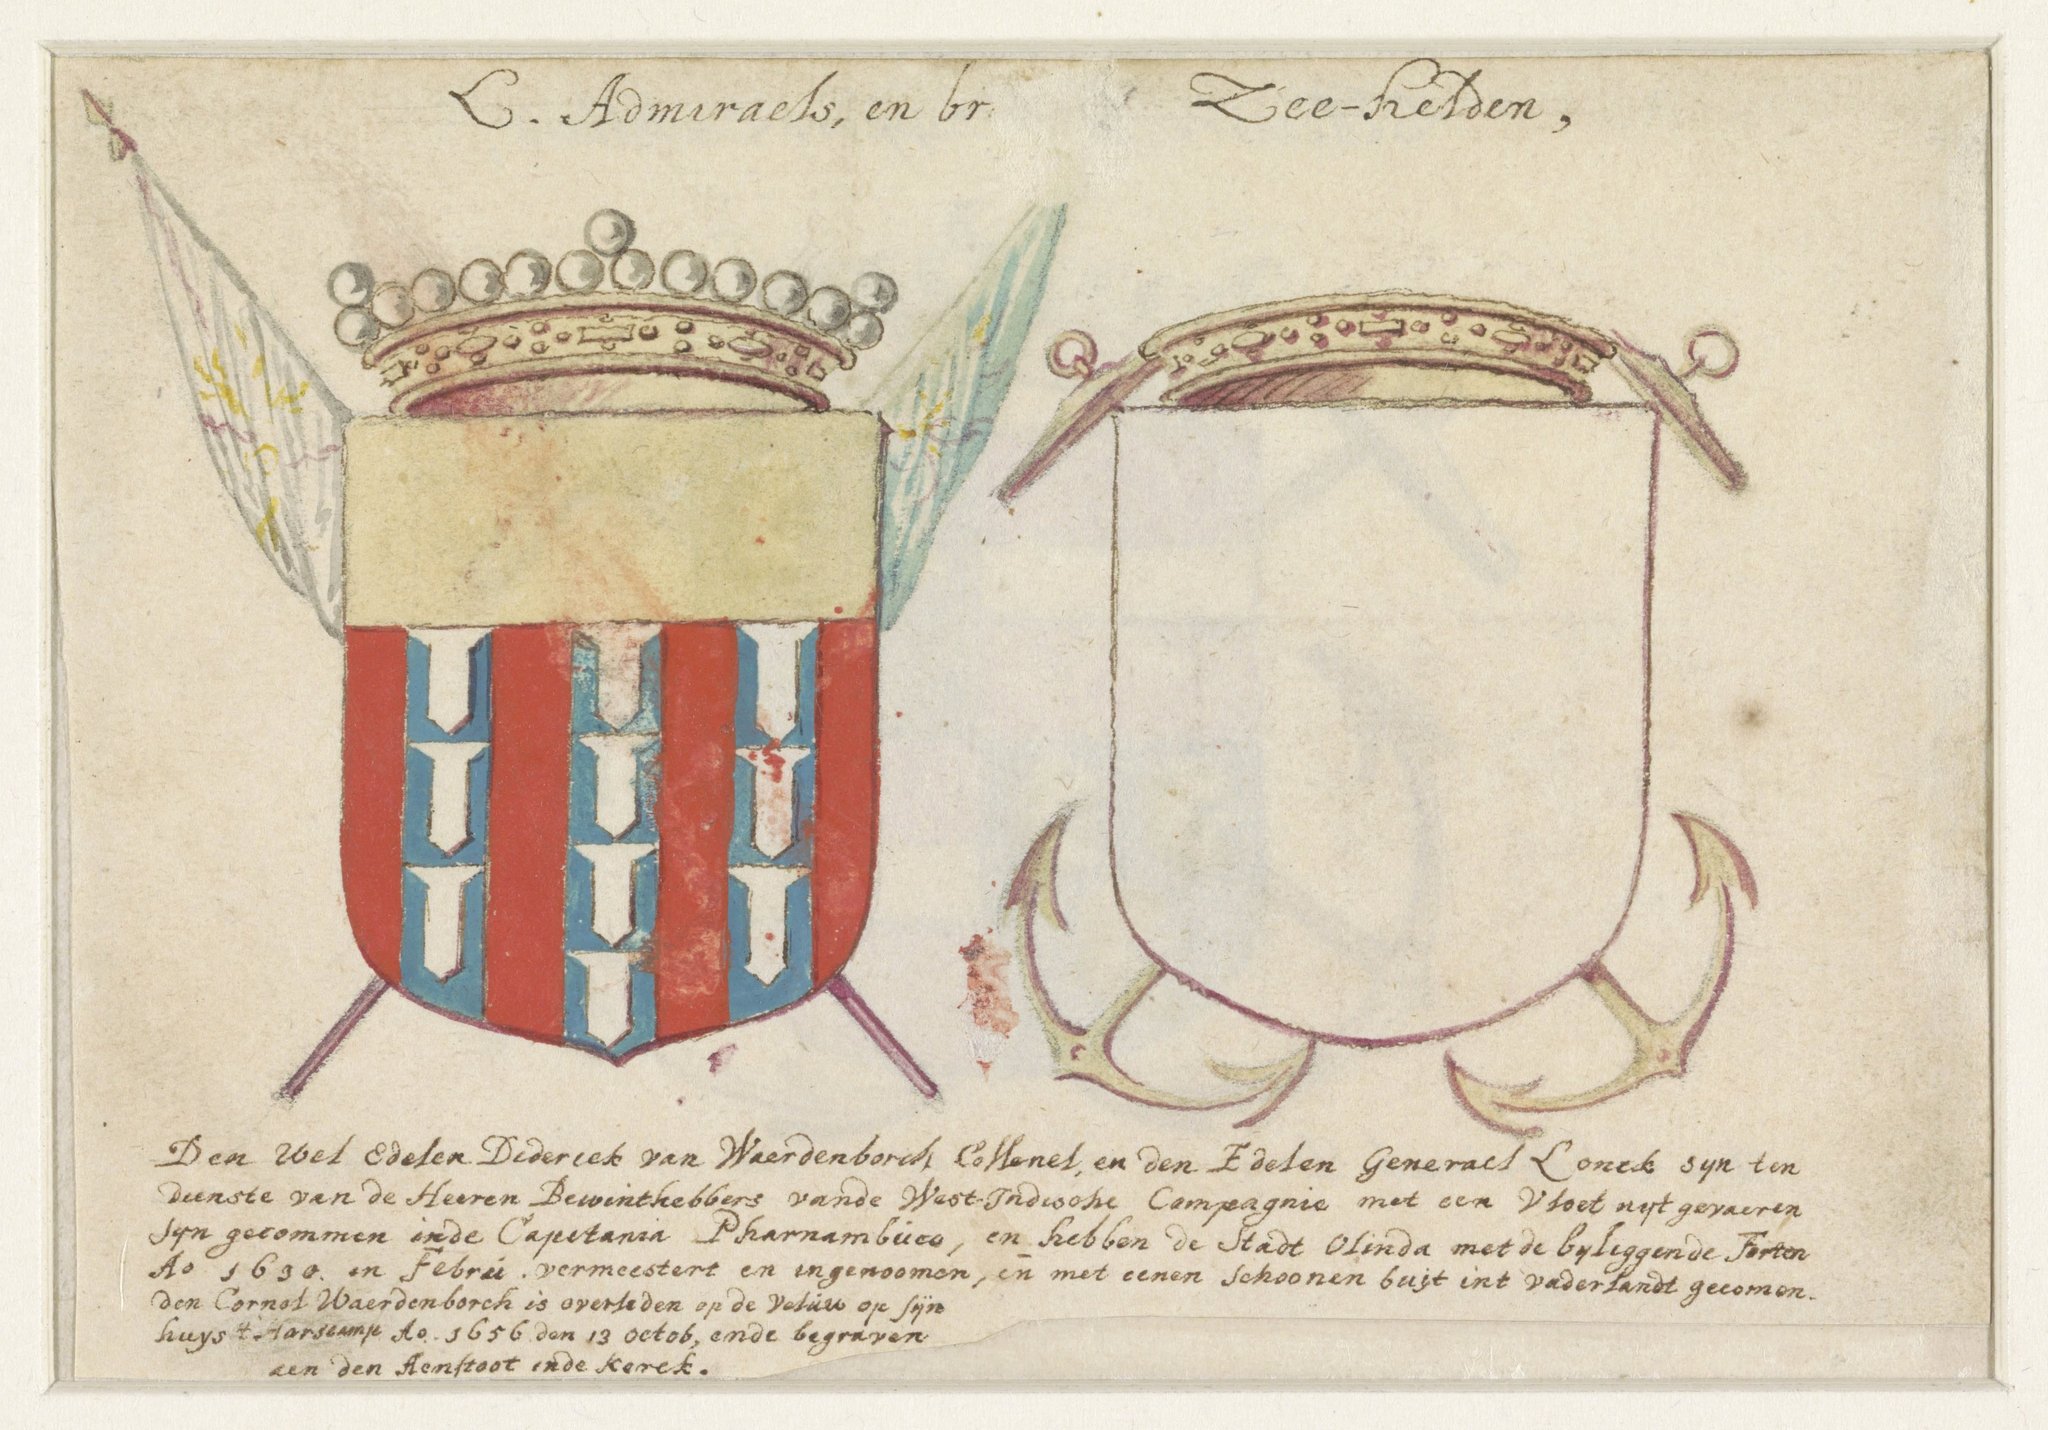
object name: drawing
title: Wapen van Diderick van Waerdenborch en een leeg wapenschild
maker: Anonymous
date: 1656-1699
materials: chalk, ink, paper, watercolor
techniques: brush, pen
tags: armorial bearing, heraldry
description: Met onder de wapenschilden handgeschreven tekst met informatie over Van Waerdenborch.